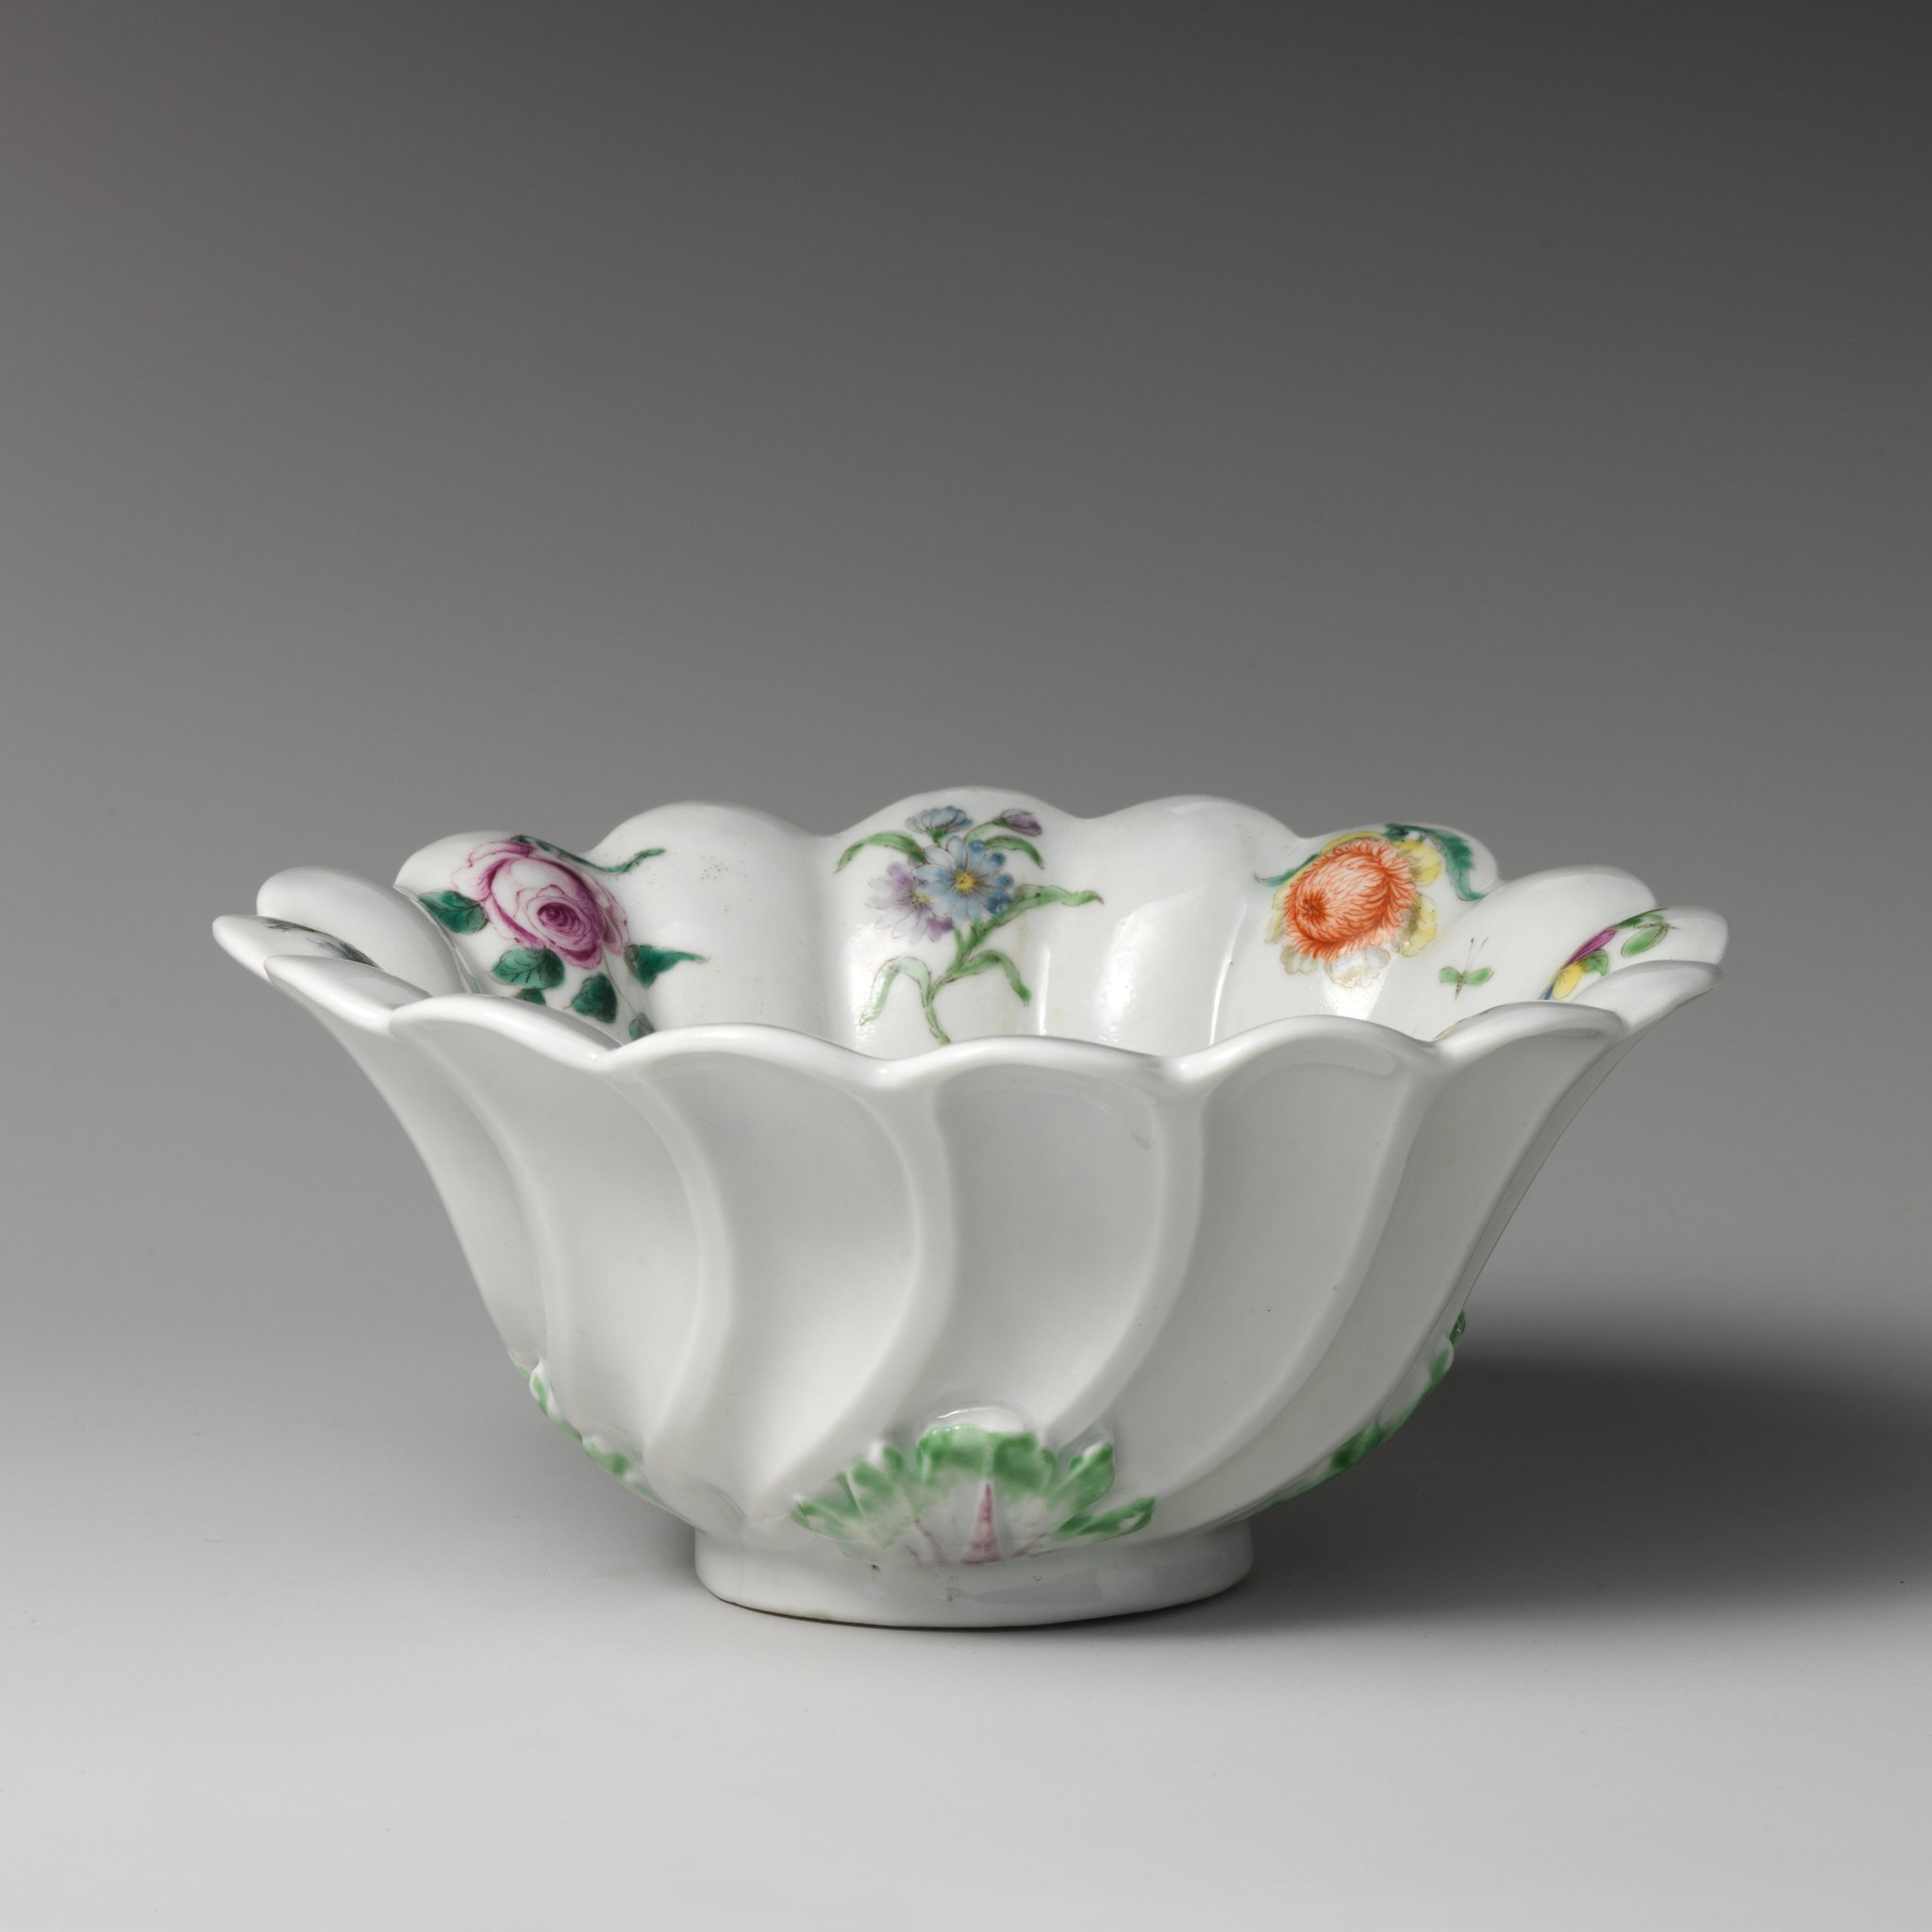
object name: bowl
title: Bowl (from a tea set)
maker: worcester factory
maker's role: manufactory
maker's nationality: british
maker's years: 1751-2008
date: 1752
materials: soft paste porcelain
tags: flowers